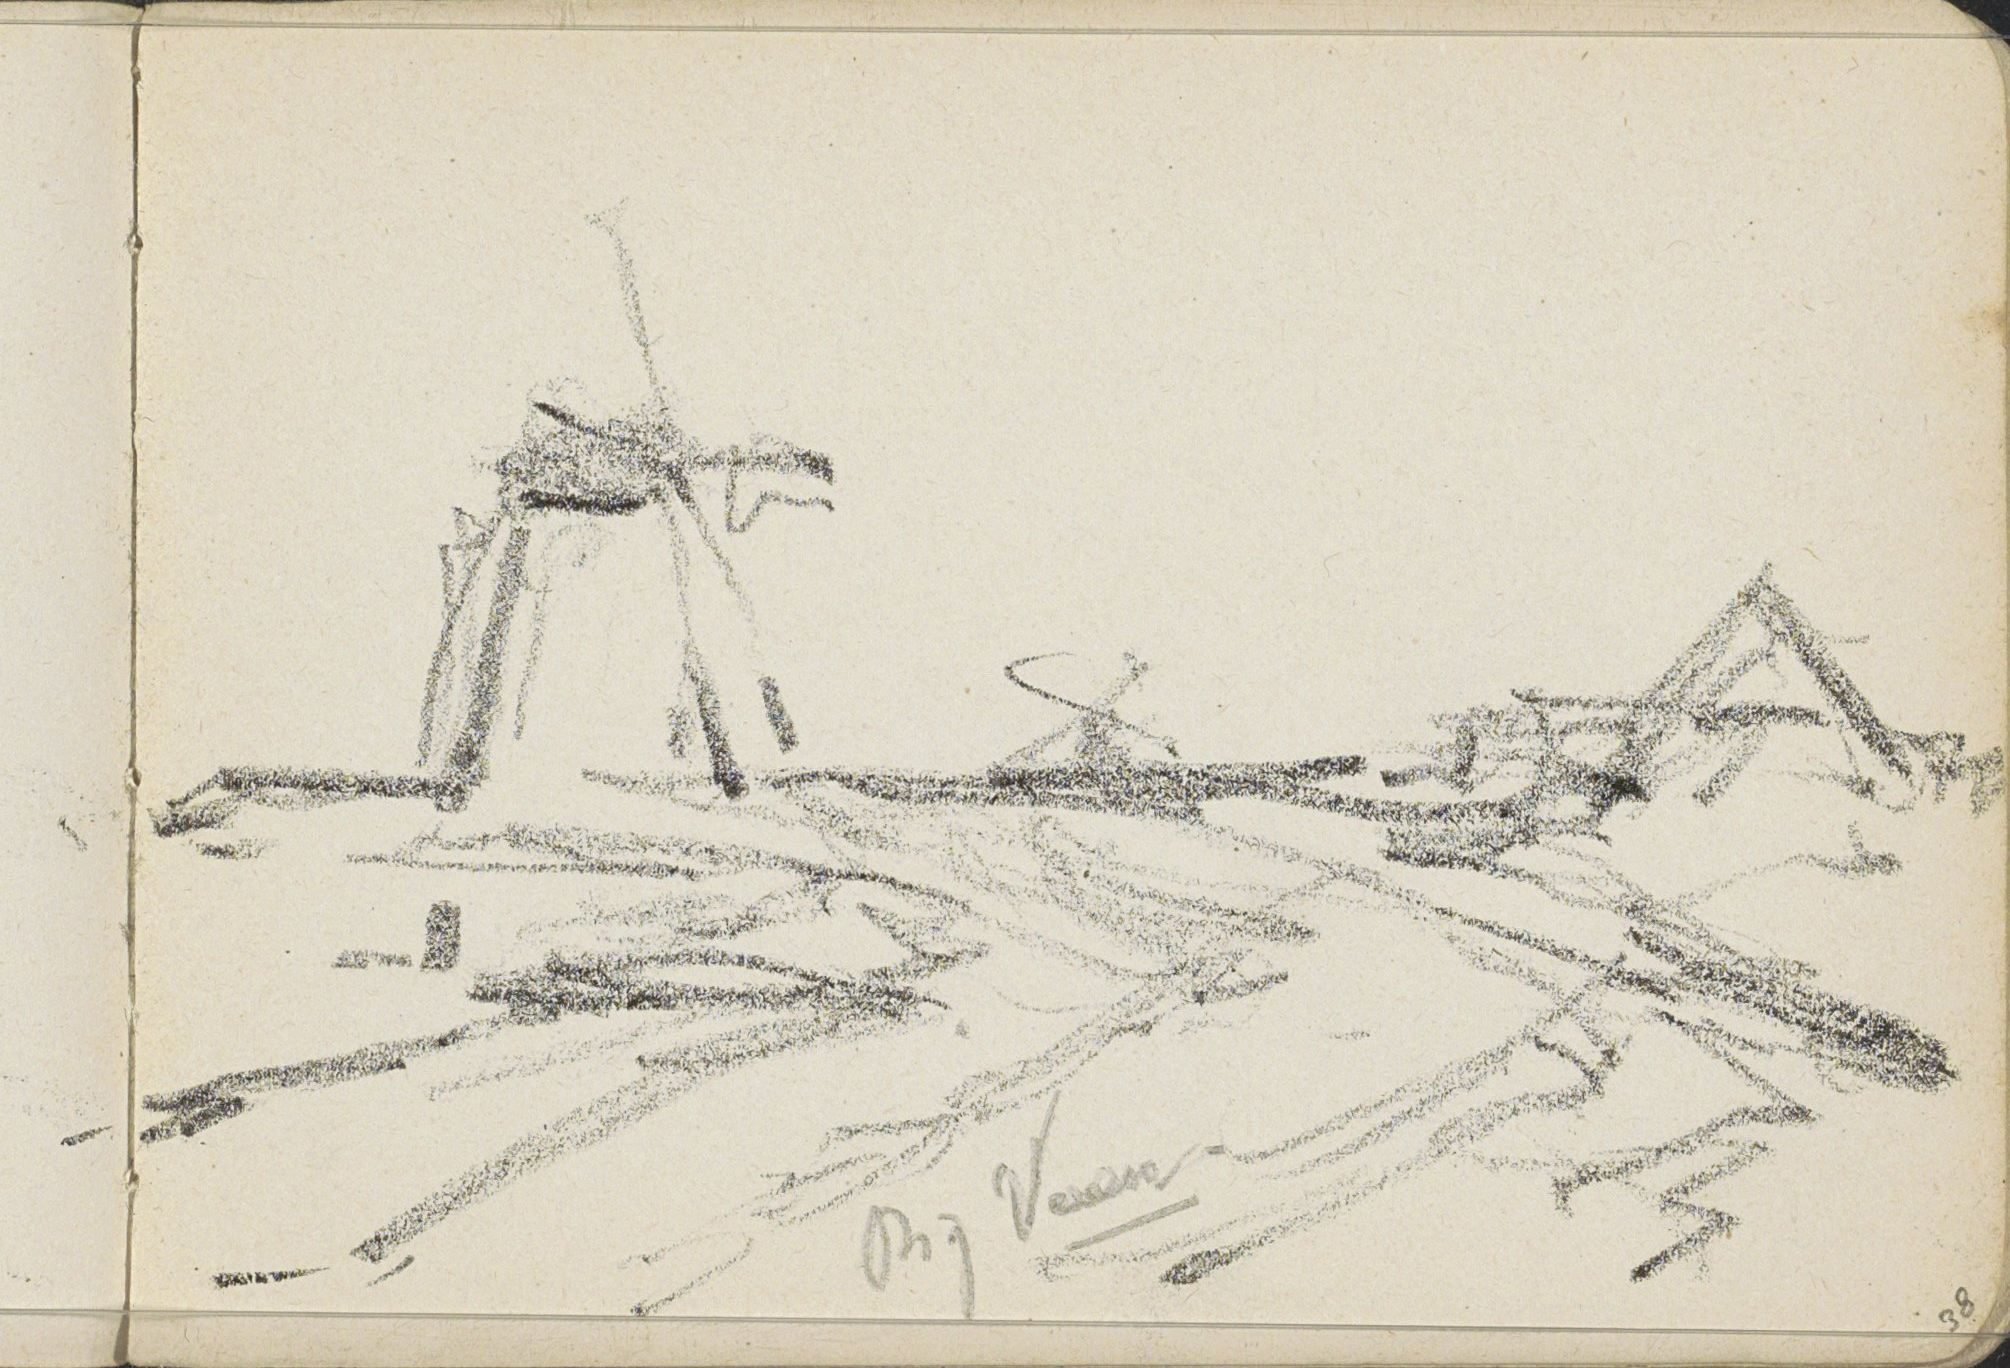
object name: sketchbook leaf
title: Molen De Hoop bij Veen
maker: willem cornelis rip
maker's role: draughtsman, painter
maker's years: 1856-1922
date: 1905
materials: chalk, paper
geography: veen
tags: windmill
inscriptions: annotation: ‘Bij Veen’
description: Blad 38 recto uit een schetsboek met 42 bladen.